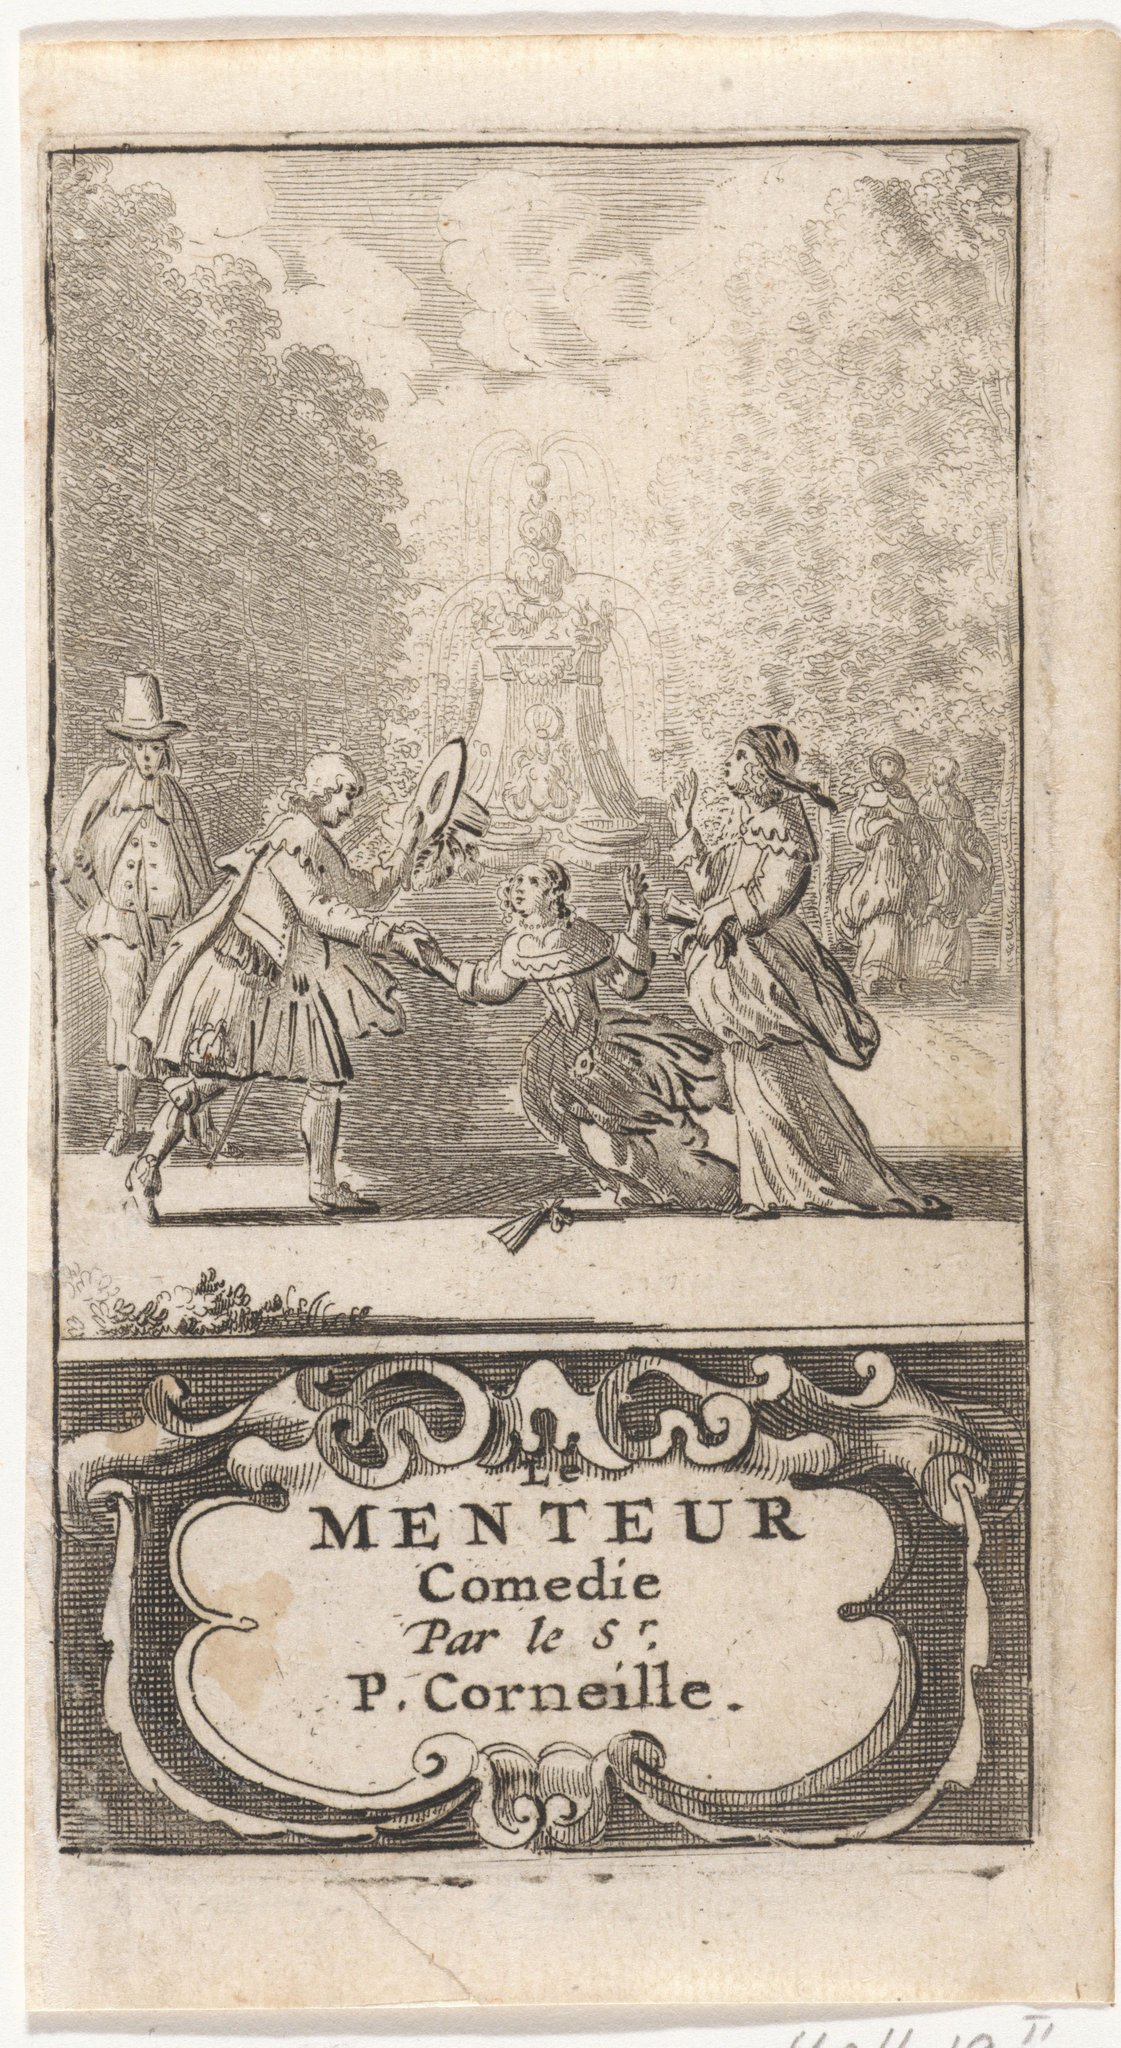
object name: titelblad, titelpagina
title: Titelpagina voor: Corneille, Pierre. Le menteur. Comedie, 1663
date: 1682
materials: paper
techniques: etching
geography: netherlands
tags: introducing, title-page, public gardens, park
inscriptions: collector's mark: Lugt 2228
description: Dorante begroet Clarice en Lucrece bij een fontein in de Parijse Tuilerieën. Achter hem staat een man. Rechts wandelen twee figuren. Onder een cartouche met de titel.